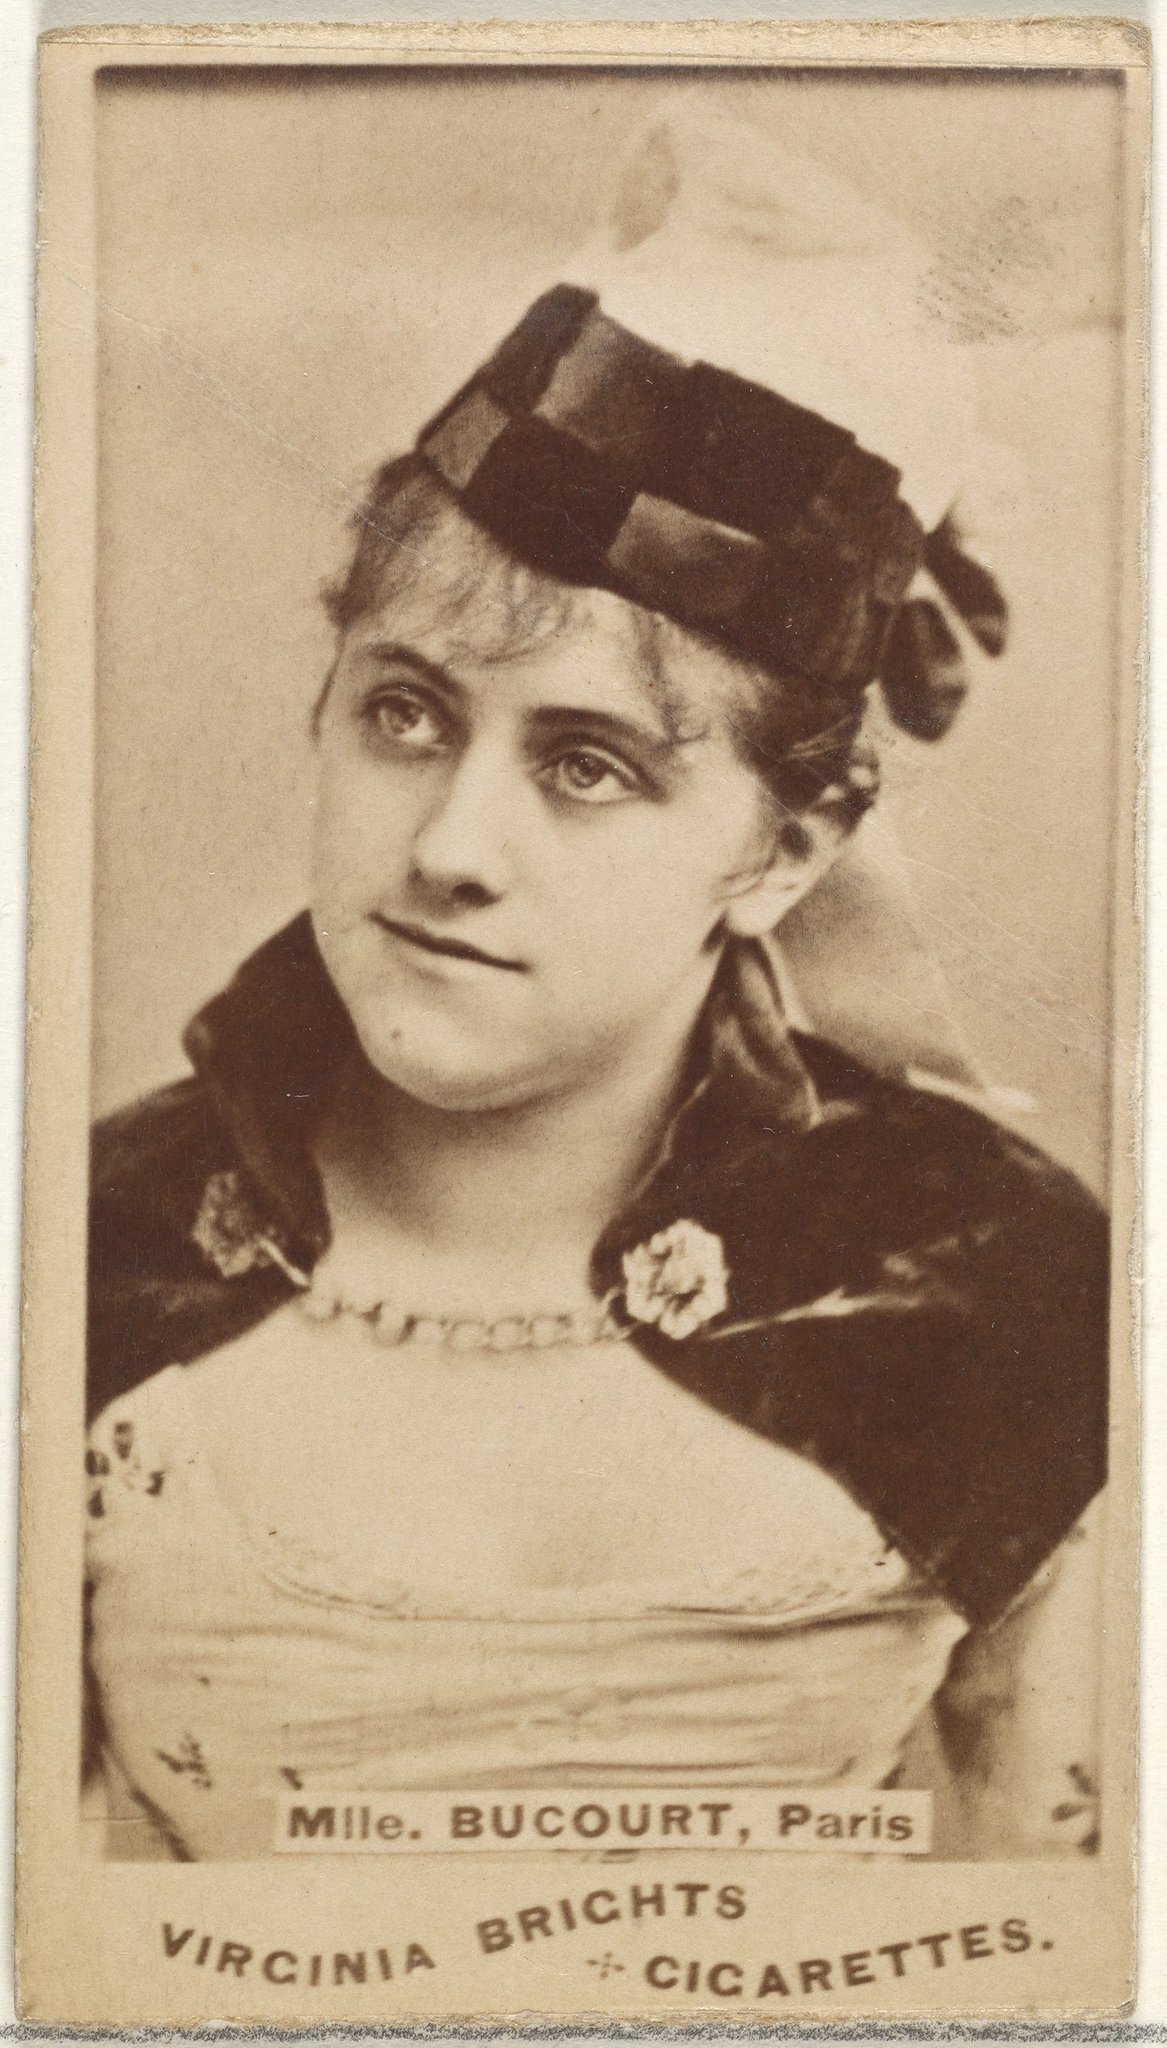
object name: photograph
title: Mlle. Bucourt, Paris, from the Actors and Actresses series (N45, Type 1) for Virginia Brights Cigarettes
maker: allen & ginter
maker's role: publisher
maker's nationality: american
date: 1888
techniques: albumen silver print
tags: portraits,women,actresses